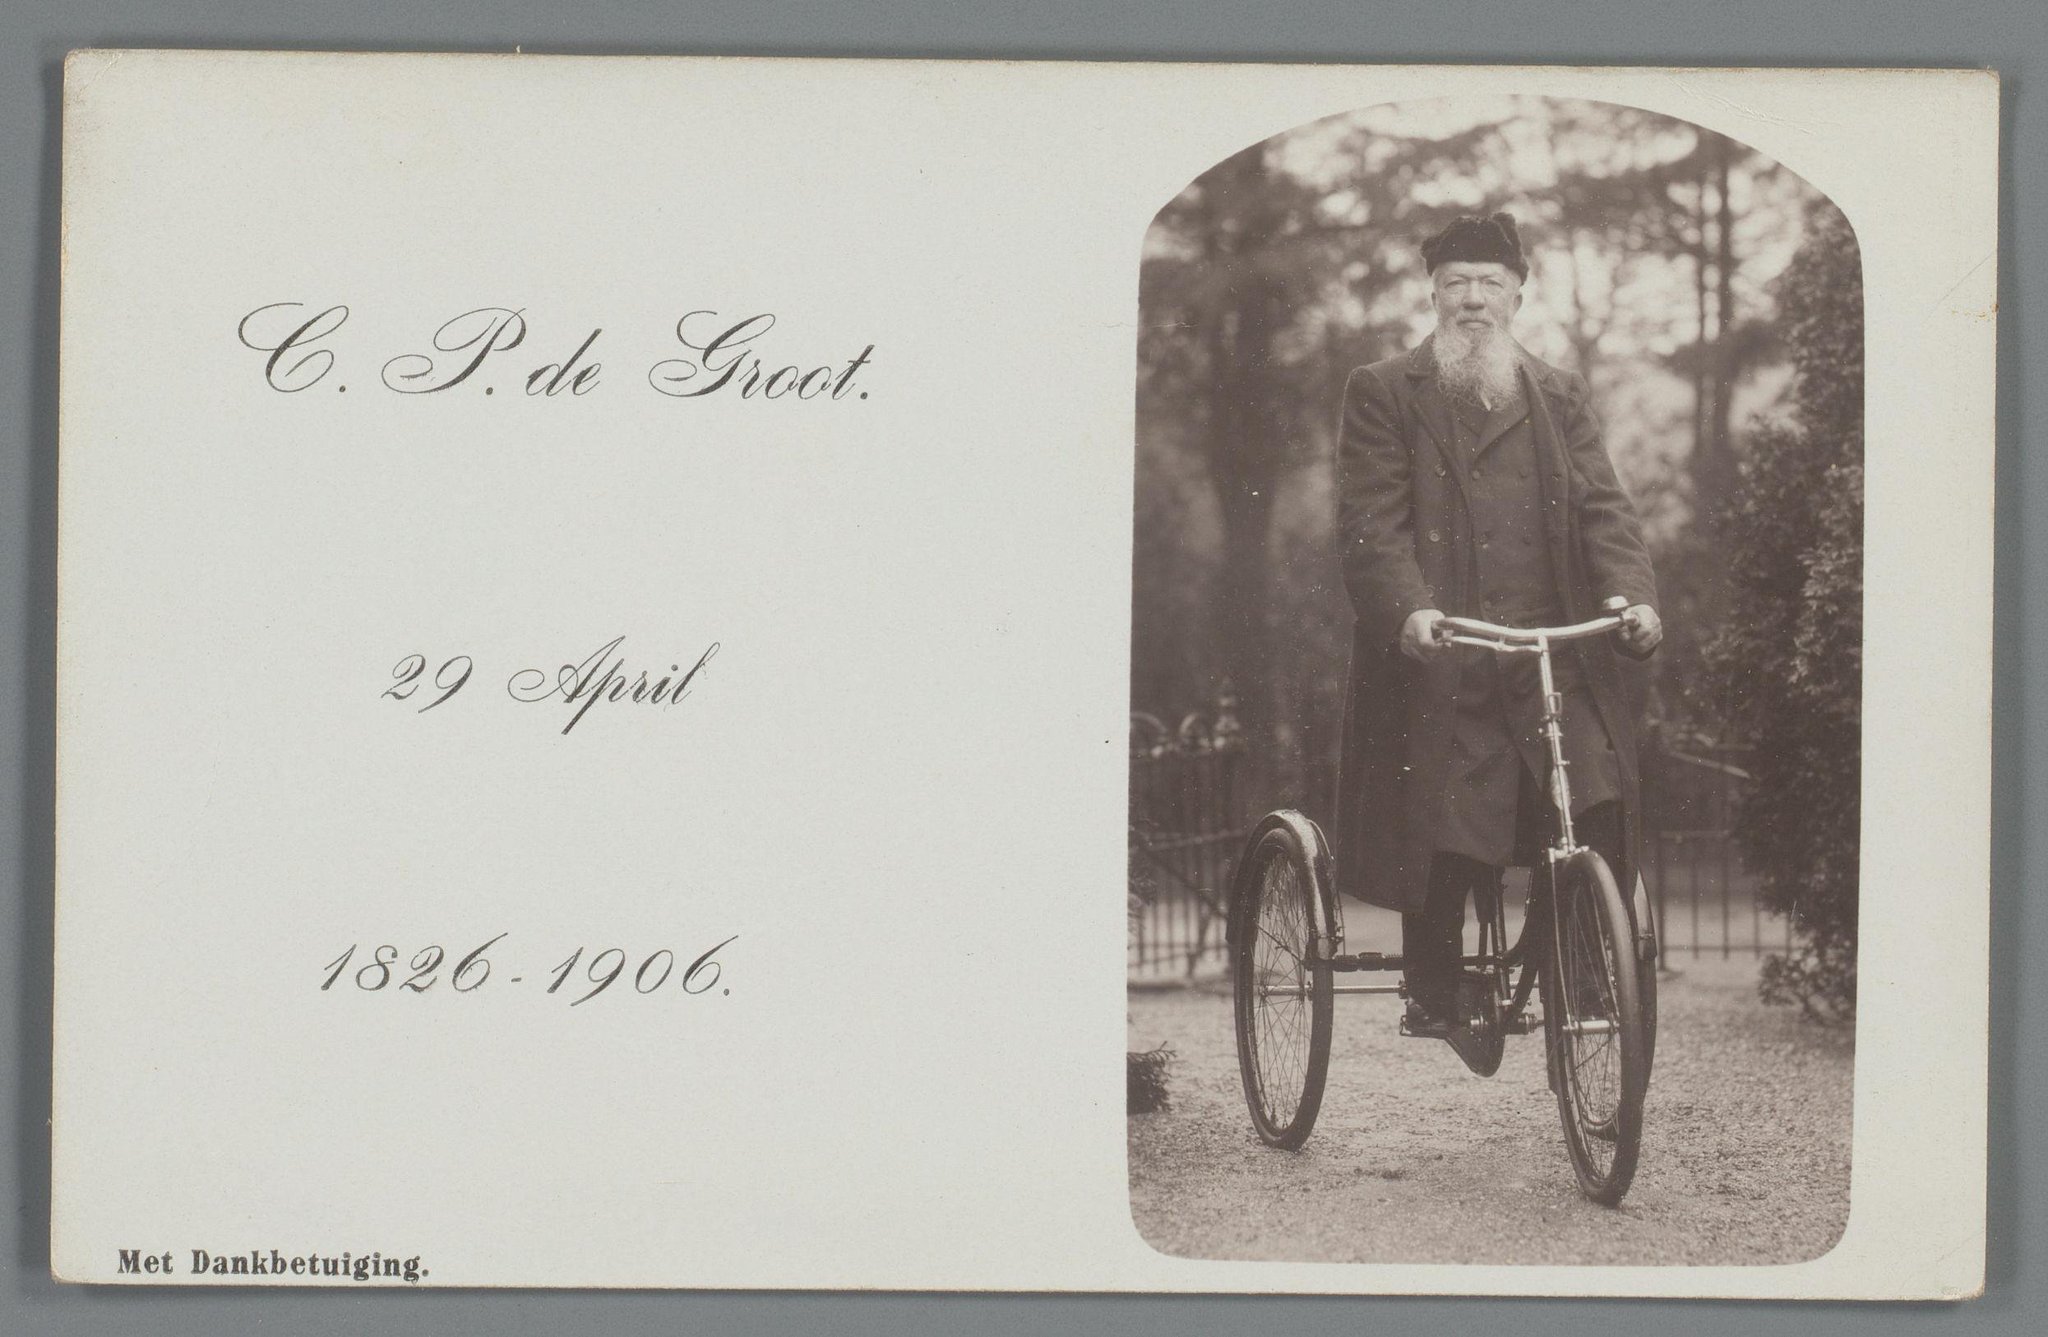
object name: photograph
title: Portret van C.P. de Groot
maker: Anonymous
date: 1906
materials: paper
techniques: collodion silver print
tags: historical persons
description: Bedankkaart van de heer C.P. de Groot voor de getoonde belangstelling bij zijn tachtigste verjaardag op 29 april 1906, met een portret van de jarige.